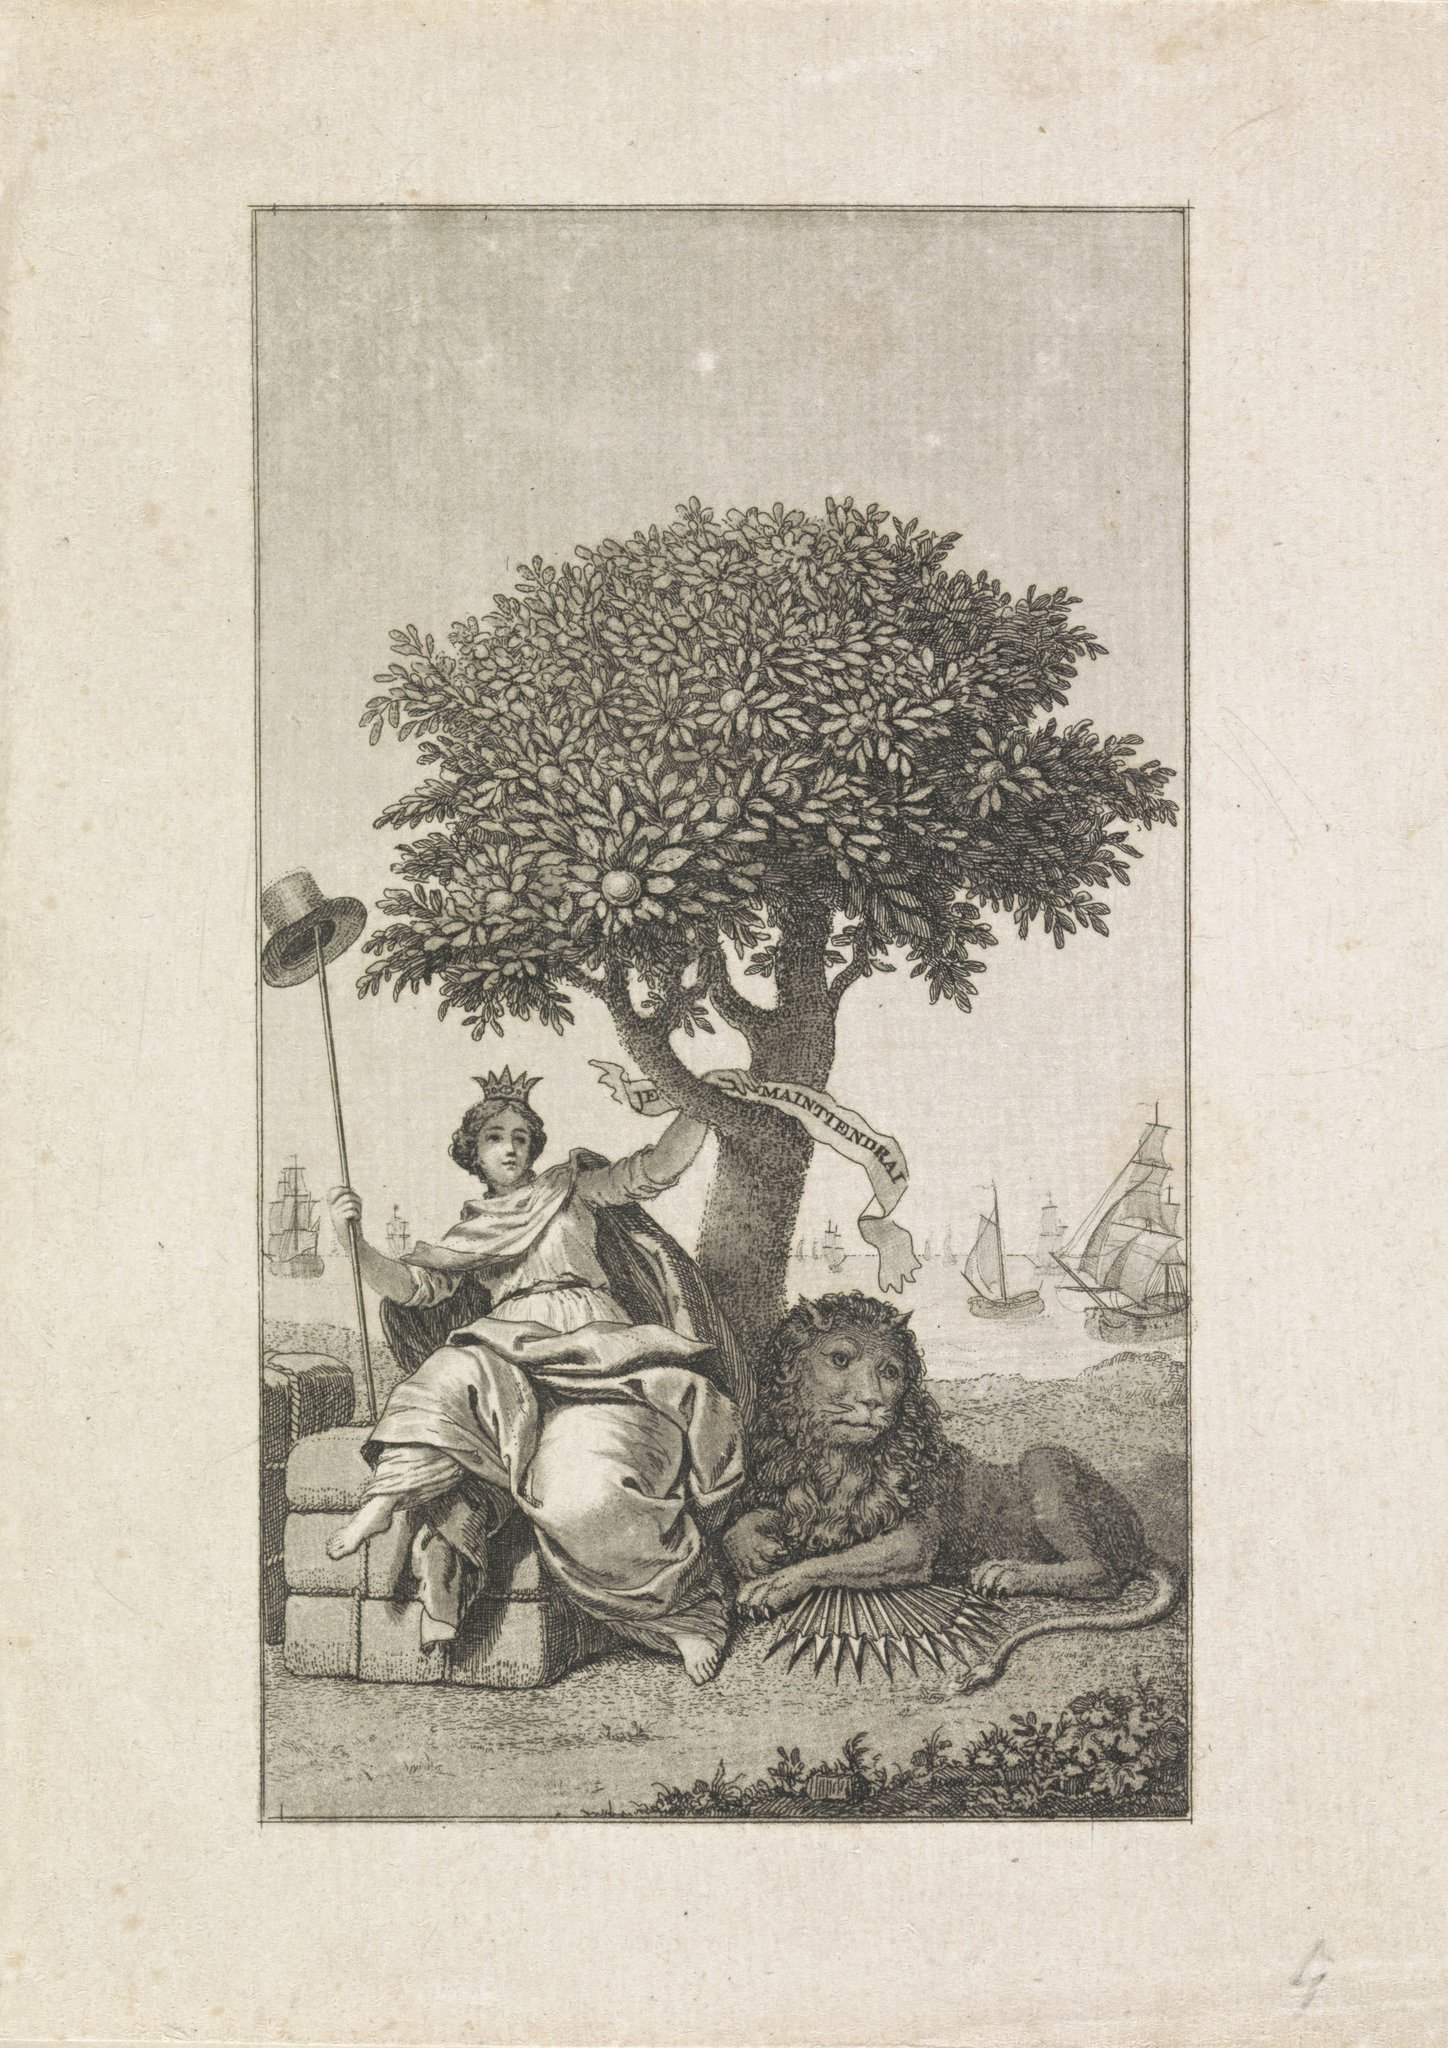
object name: print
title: Allegorie op het herstel van de vrijheid in Nederland, 1814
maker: Anonymous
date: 1814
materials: paper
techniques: aquatint, etching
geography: netherlands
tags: personifications of countries, nations, states, districts, etc., merchant shipping, shipping trade, netherlands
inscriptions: collector's mark: Lugt 2228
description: Allegorie op het herstel van de vrede en vrijheid in Nederland waardoor de handel en koopvaardij weer kan bloeien, 1814. De Nederlandse Maagd met vrijheidsland en hoed zittend op een baal koopwaar, onder de Oranjeboom waaraan een bandelrol waarop 'Je Maintiendrai'. Rechts van haar de Nederlandse Leeuw met een pijlenbundel onder de poot. Op de achtergrond schepen op zee.